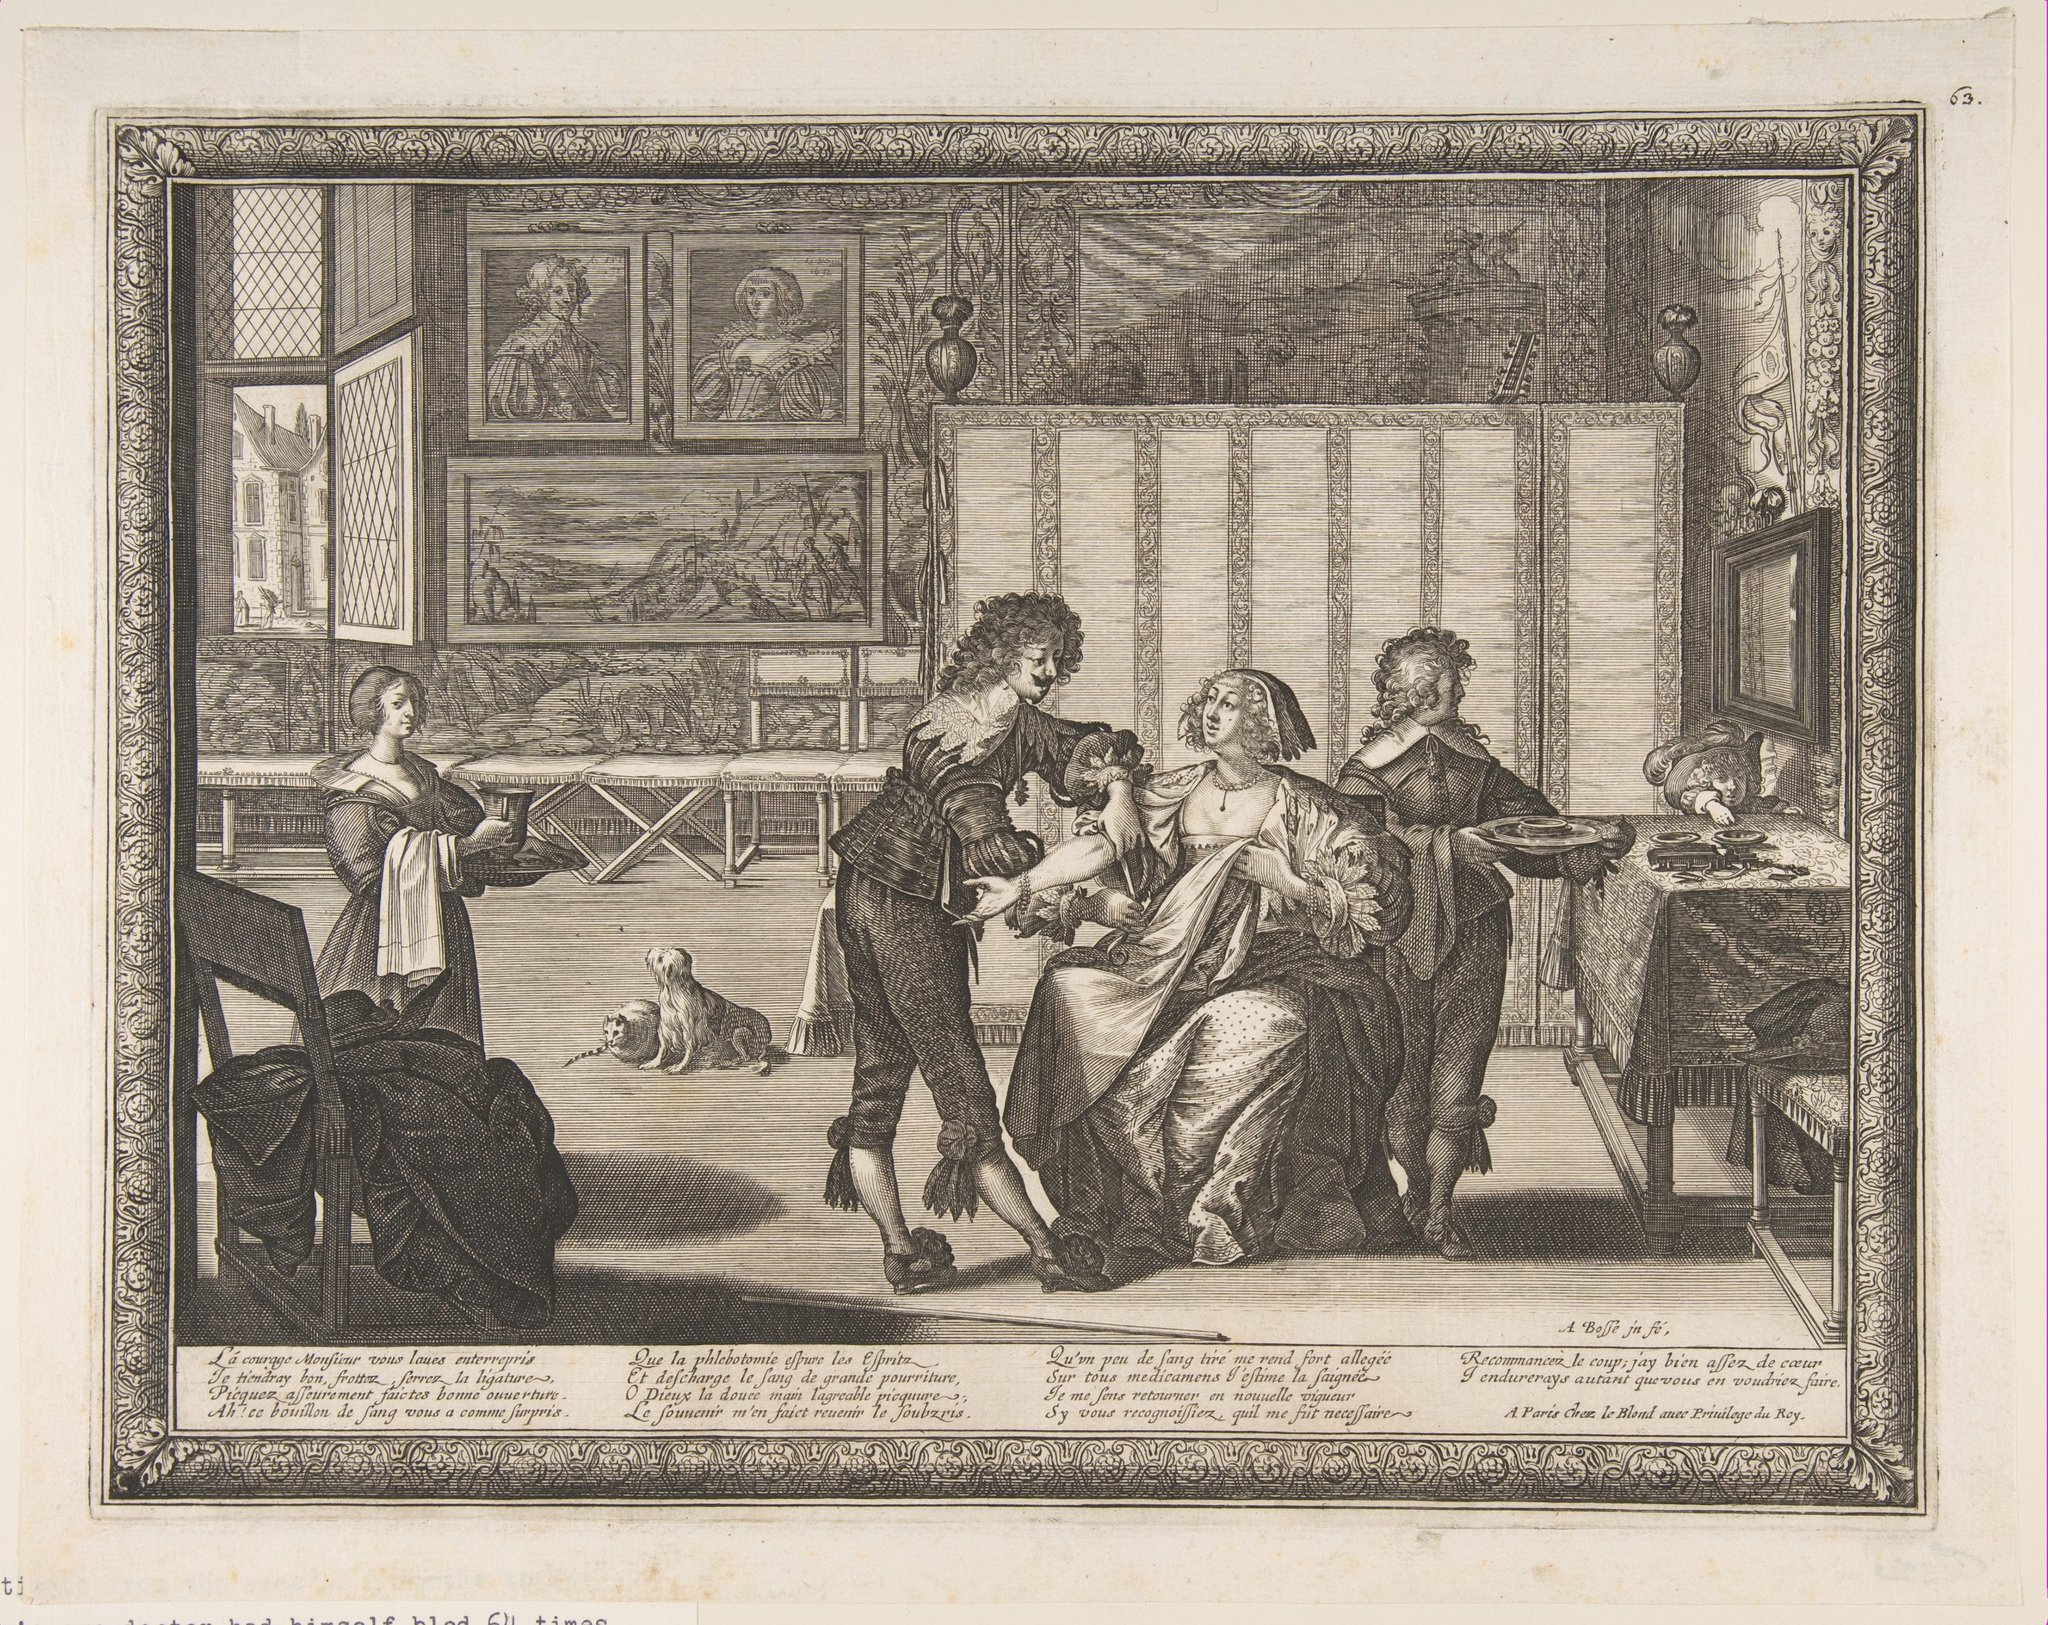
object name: print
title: The Surgeon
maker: abraham bosse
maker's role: artist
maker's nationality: french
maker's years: 1602-1676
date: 1632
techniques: engraving, etching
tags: interiors,men,women,cats,dogs,doctors